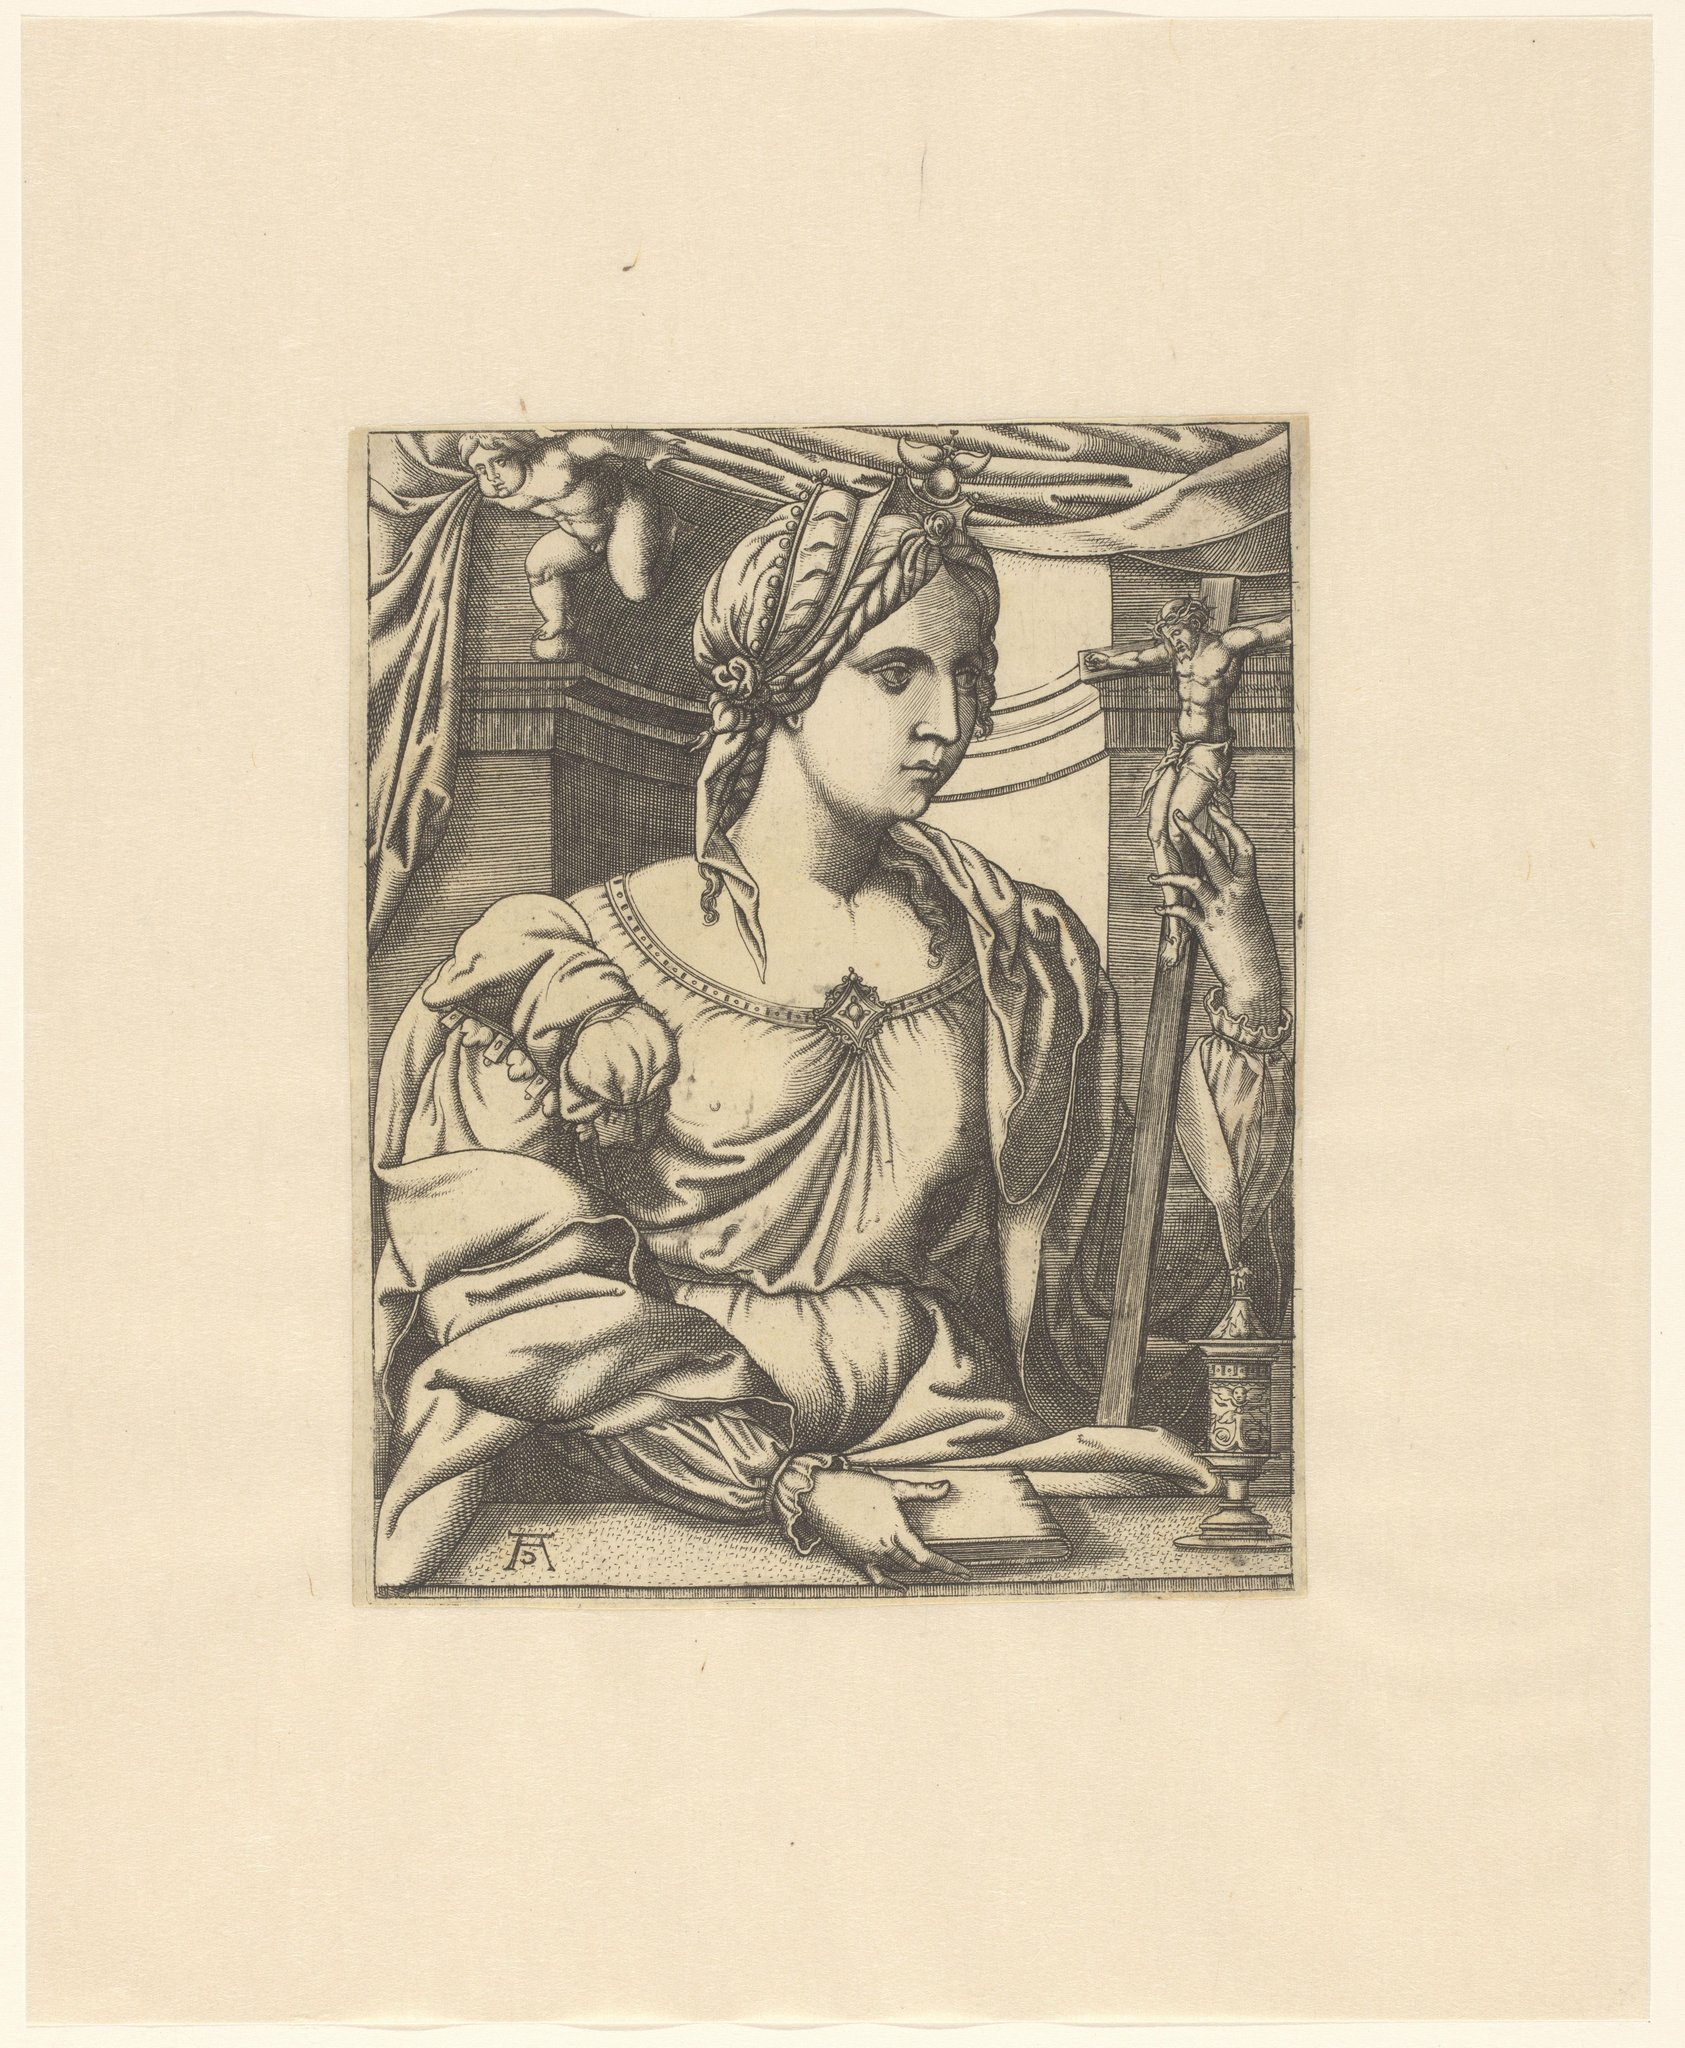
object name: print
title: Maria Magdalena ten halven lijve met crucifix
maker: monogrammist ac (16e eeuw)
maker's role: print maker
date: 1520-1540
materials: paper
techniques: engraving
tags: the penitent harlot mary magdalene; possible attributes: book (or scroll), crown, crown of thorns, crucifix, jar of ointment, mirror, musical instrument, palm-branch, rosary, scourge - portrait of female saint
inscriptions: collector's mark: Lugt 2760, collector's mark: Lugt 2228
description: Maria Magdalena, voorgesteld in weelderige kledij en met hoofdtooi, houdt een crucifix in haar linker- en een boek in haar rechterhand.